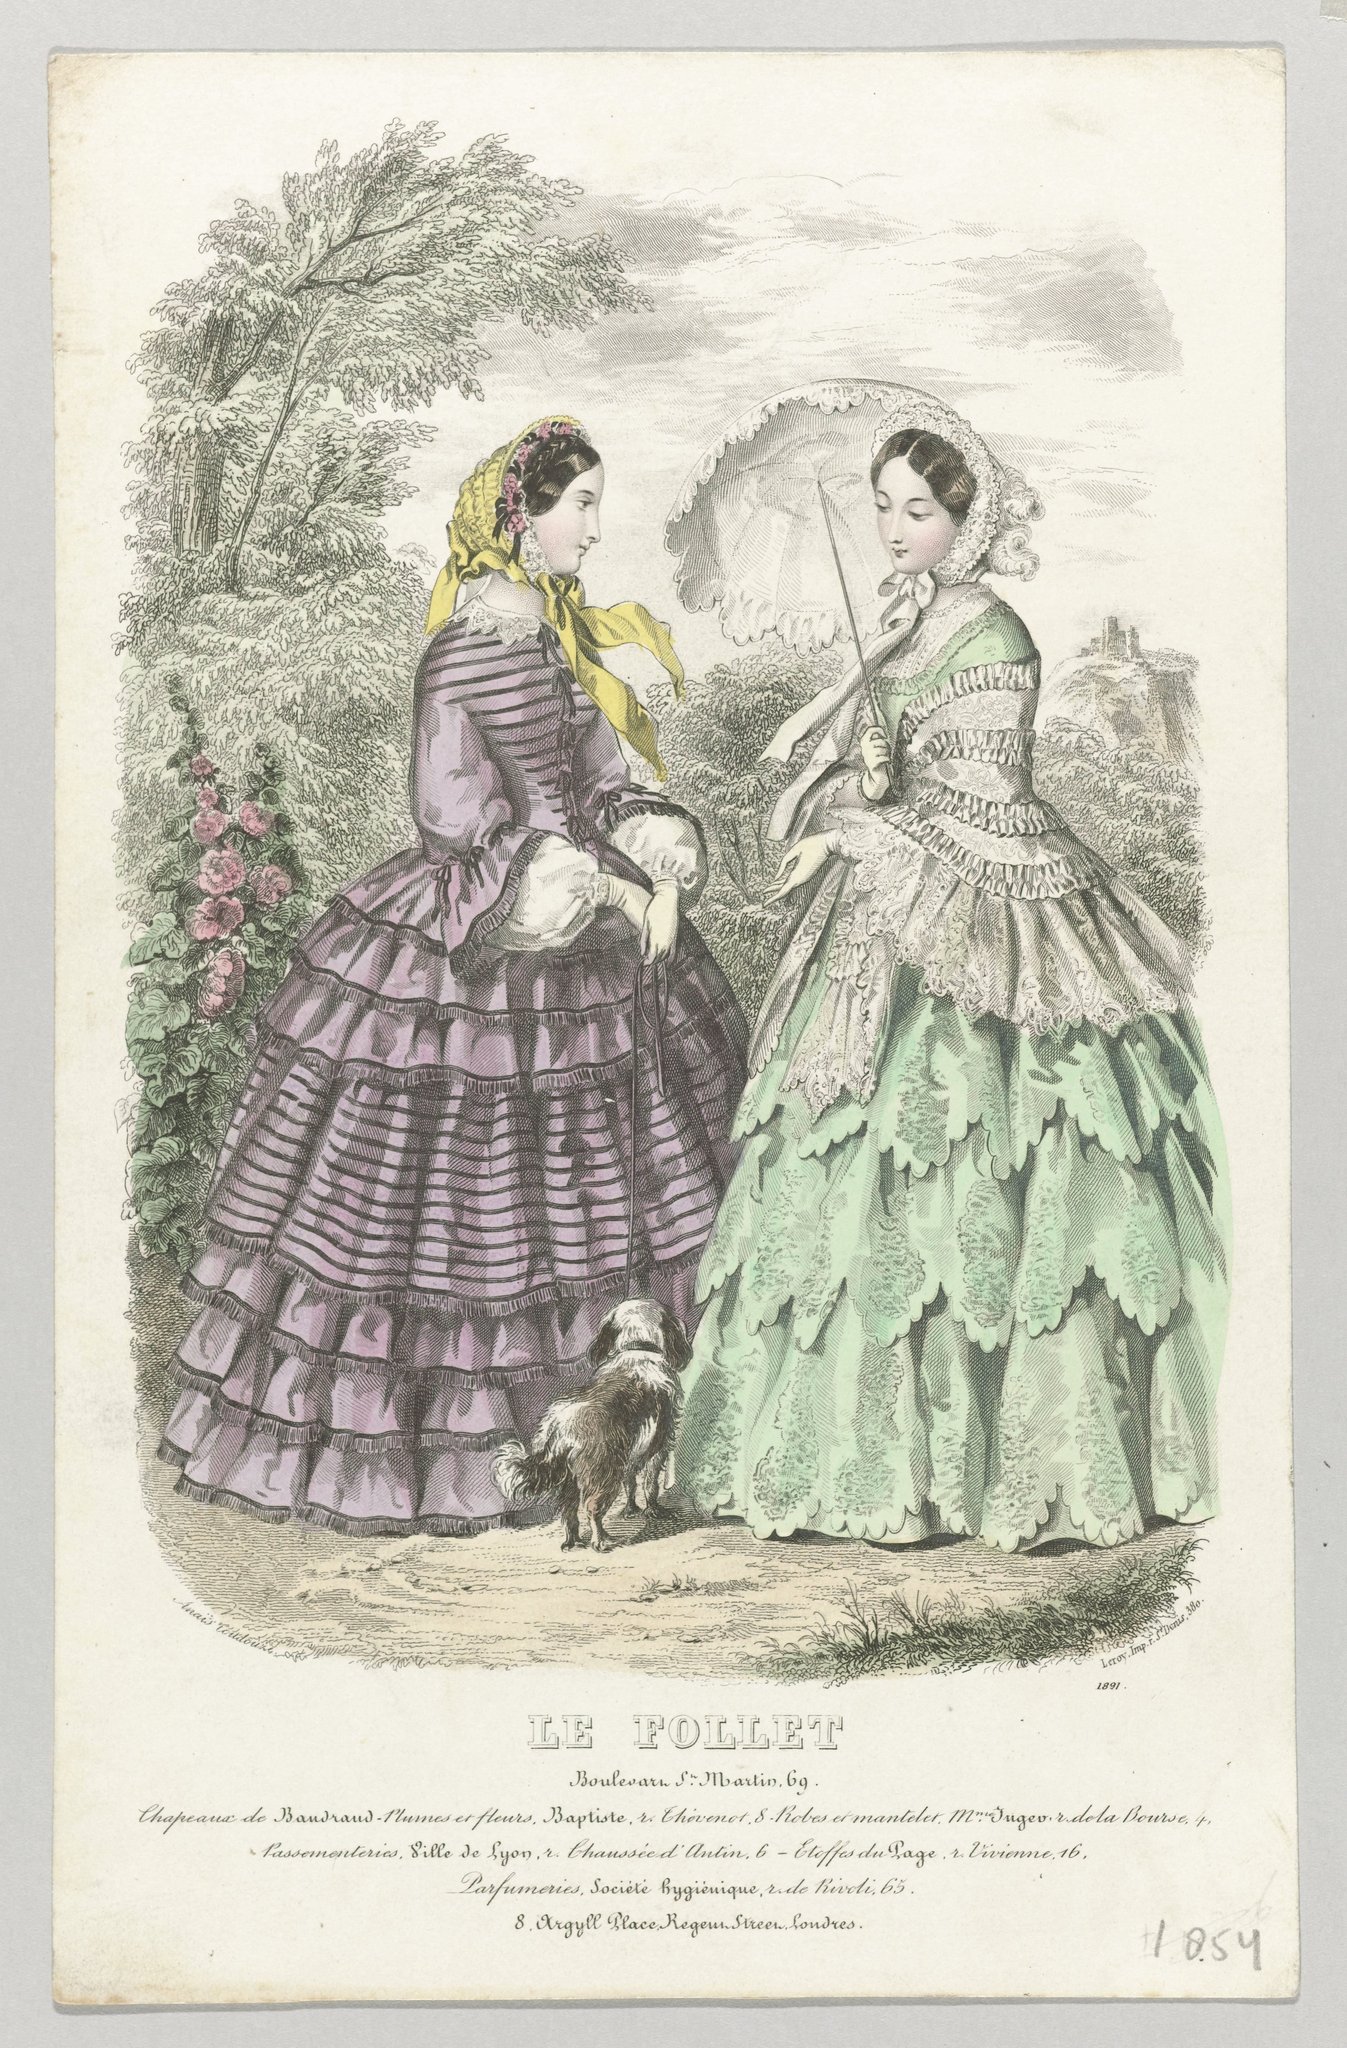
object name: fashion print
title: Le Follet, 1854, No. 1891 : Chapeaux de Baudraud (...)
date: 1854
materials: paper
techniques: engraving, hand coloring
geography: paris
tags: flowers, gloves, mittens (short gloves) (+ women's clothes), head-gear (fanchon) (+ women's clothes), clothing for the upper part of the body (mantelet) (+ women's clothes), head-gear: cap (+ women's clothes), fashion plates, walking the dog, parasol, sunshade (+ women's clothes)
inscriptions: address: ‘Boulevart S.t Martin, 69 / 8, Argyll Place, Regent Street, Londres.’, caption: ‘Chapeaux de Baudrand- Plumes et fleurs, Baptiste, r. Chévenot,8 - Robes et mantelet, M.me Inger, r. de la Bourse,4. Passementeries, Ville de Lyon, r. Chaussée d'Antin,6 - Etoffes du Page, r. Vivienne, 16. Parfumeries, Société Hygiénique, r. de Rivoli, 65.’, title: ‘Le Follet’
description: Twee vrouwen, van wie één met parasol, met een hondje in een tuin. Volgens het onderschrift: hoeden van Baudrand. Japonnen en mantelet van Inger. Hieronder enkele regels reclametekst voor verschillende producten. Prent uit het modetijdschrift Le Follet Courrier des Salons (novembre 1829- octobre 1882).